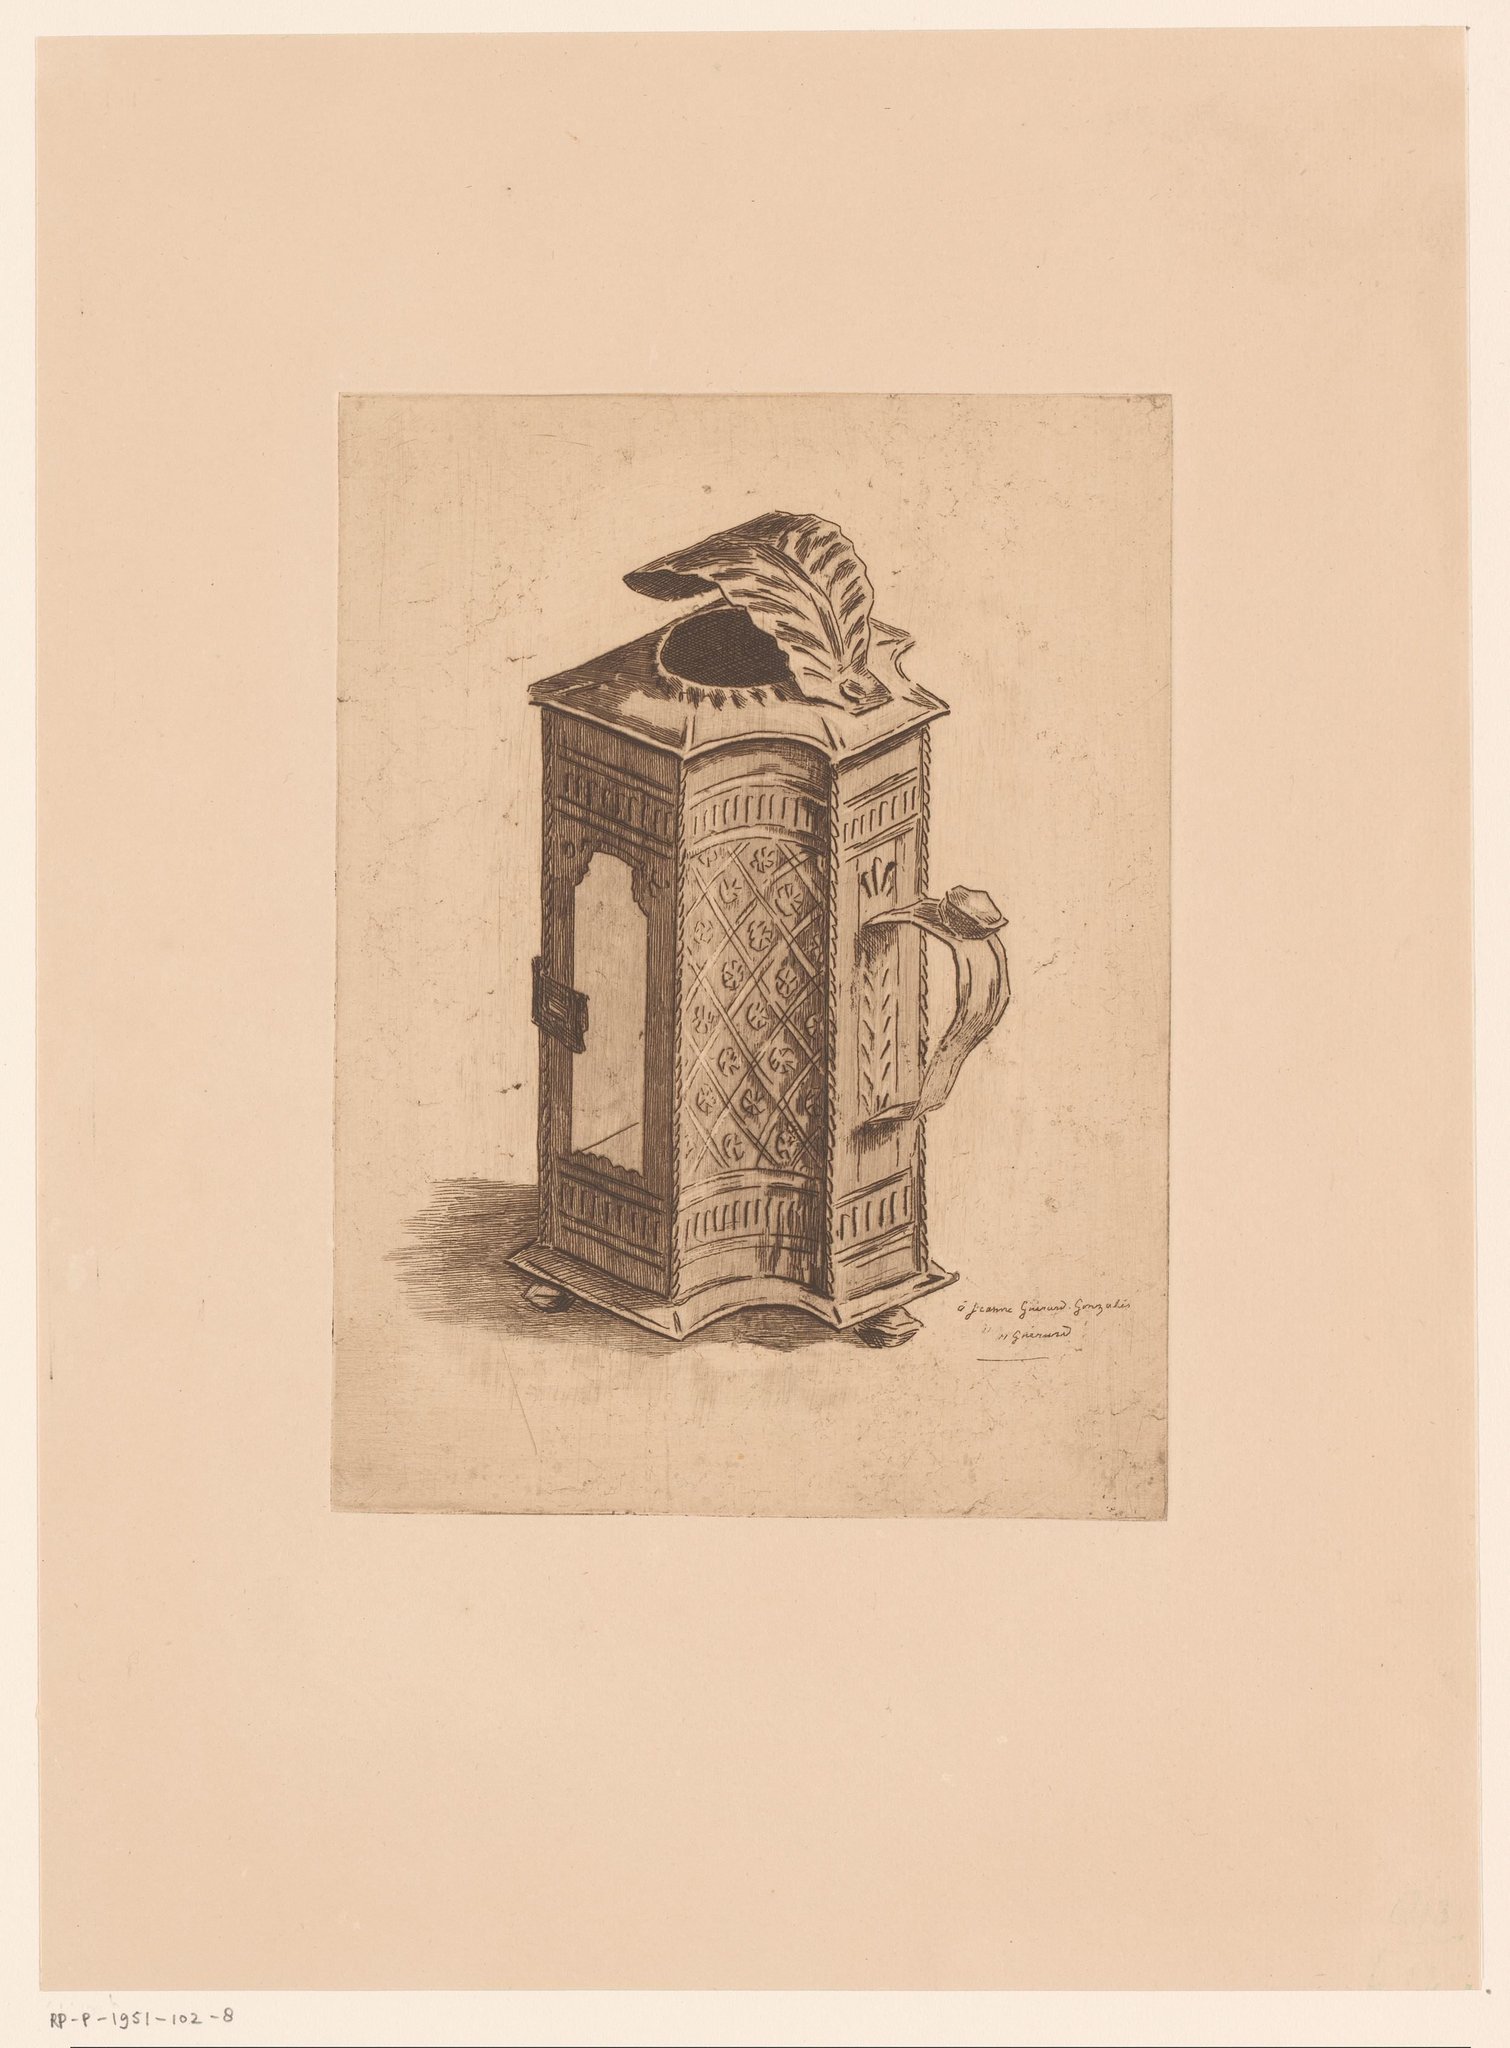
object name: print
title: Les Lanternes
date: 1876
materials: paper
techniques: etching, intaglio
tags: lantern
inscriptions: collector's mark: Lugt 2228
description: Maakt waarschijnlijk deel uit van een tiendelige serie met lantaarns.